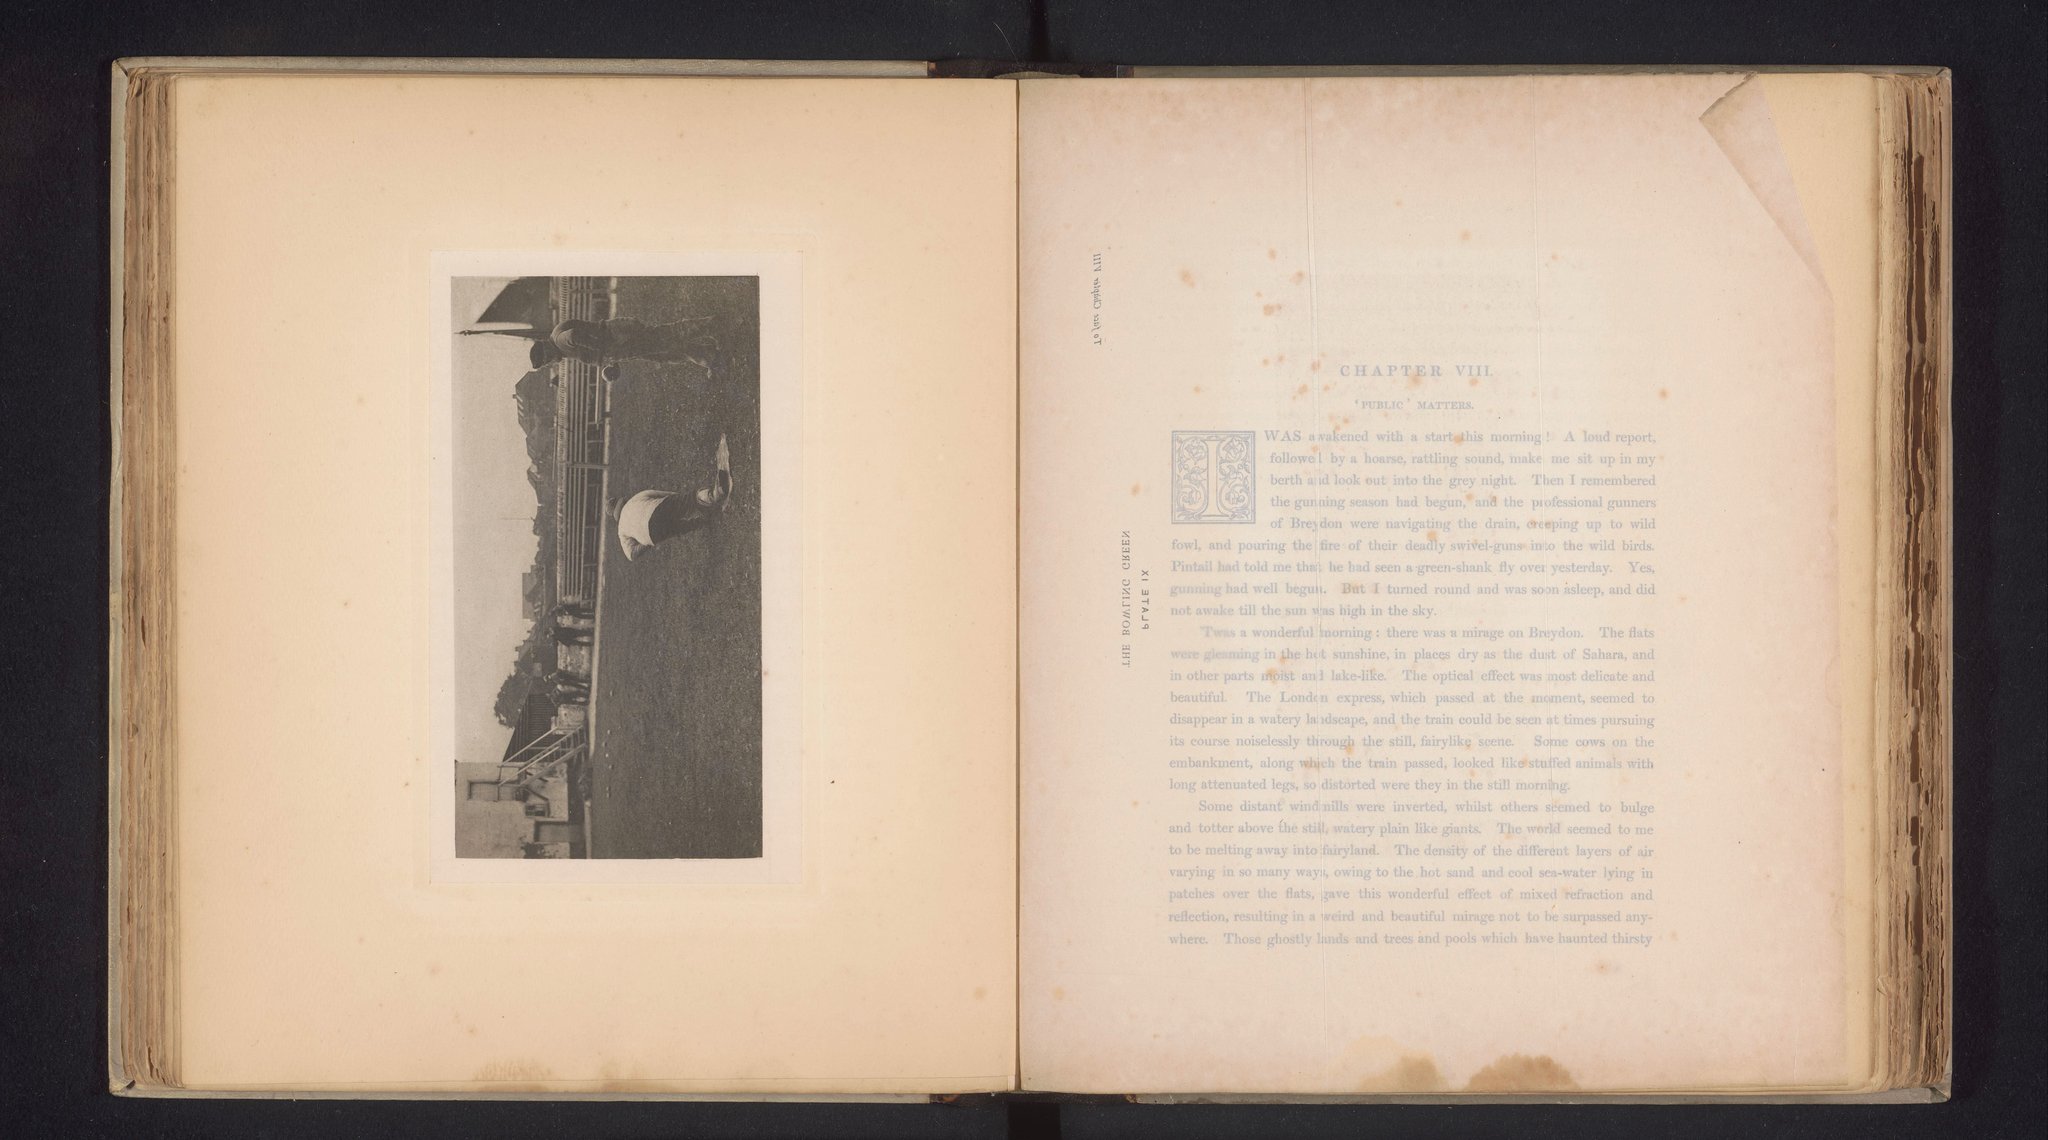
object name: photomechanical print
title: Petanque-spelende mannen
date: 1880-1890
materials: paper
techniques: photoaquatint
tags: 'jeu de boules'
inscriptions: inscription: ‘The bowling green’, number: ‘Plate IX’